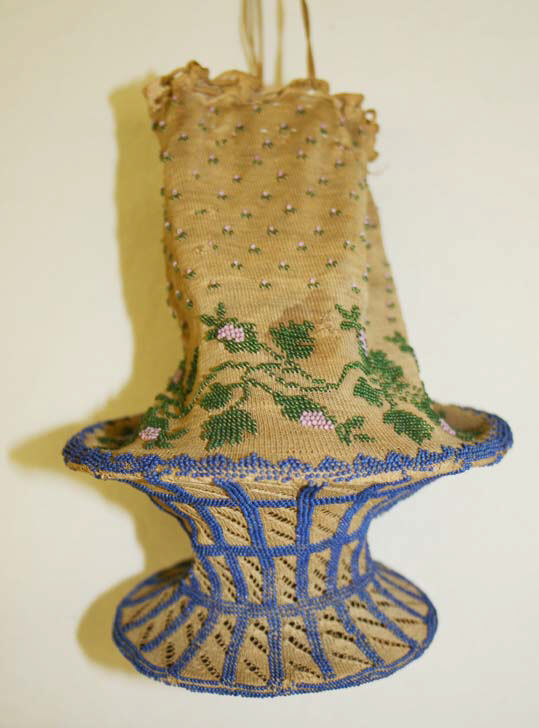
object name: purse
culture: dutch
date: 1800-1820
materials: cotton, glass